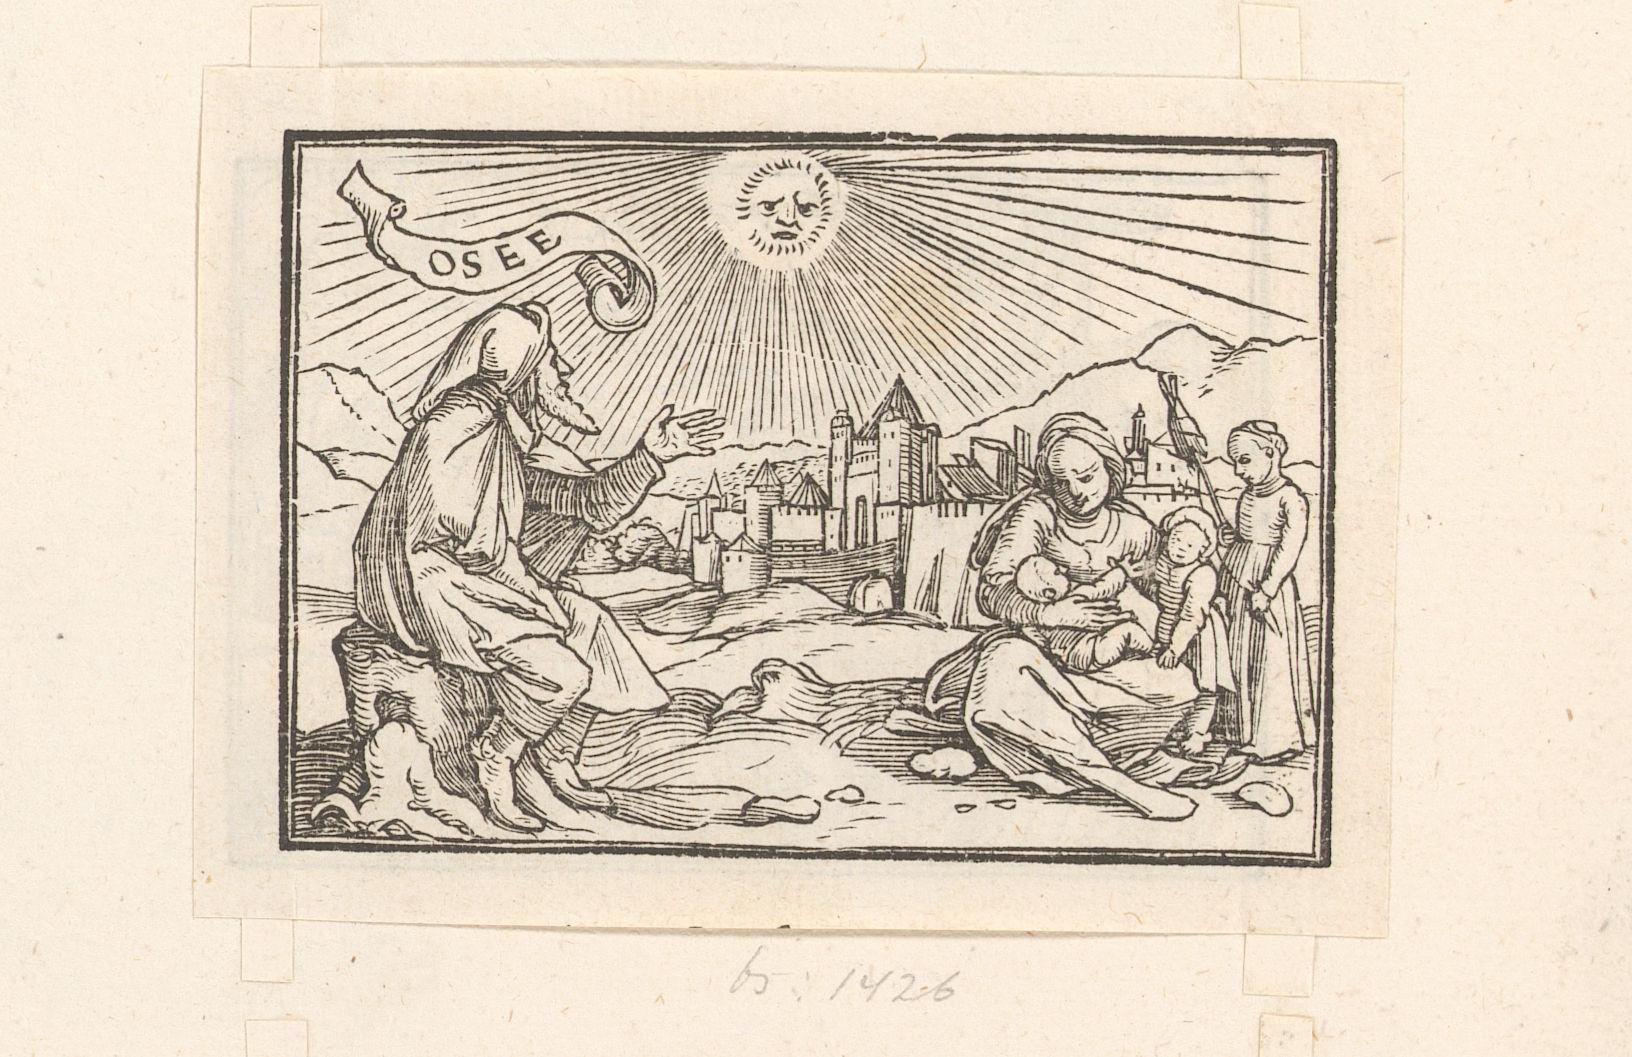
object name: album leaf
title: Hosea met zijn vrouw en drie kinderen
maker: veit rudolf specklin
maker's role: print maker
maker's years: -1550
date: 1538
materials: paper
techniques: woodcut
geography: switzerland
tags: hosea, gomer and the three children (hosea 1:3-11)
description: Boekillustratie voor het eerst gebruikt in: Biblia Utriusque Testamenti iuxta Vulgatam Translationem, Lyon, M. en G. Trechsel (voor Hugo à Porta) 1538. Later in verschillende uitgaven opnieuw gebruikt. Deze prent vermoedelijk gebruikt in één van de uitgaven uitgegeven en/of gedrukt door Jean Frellon, Lyon.